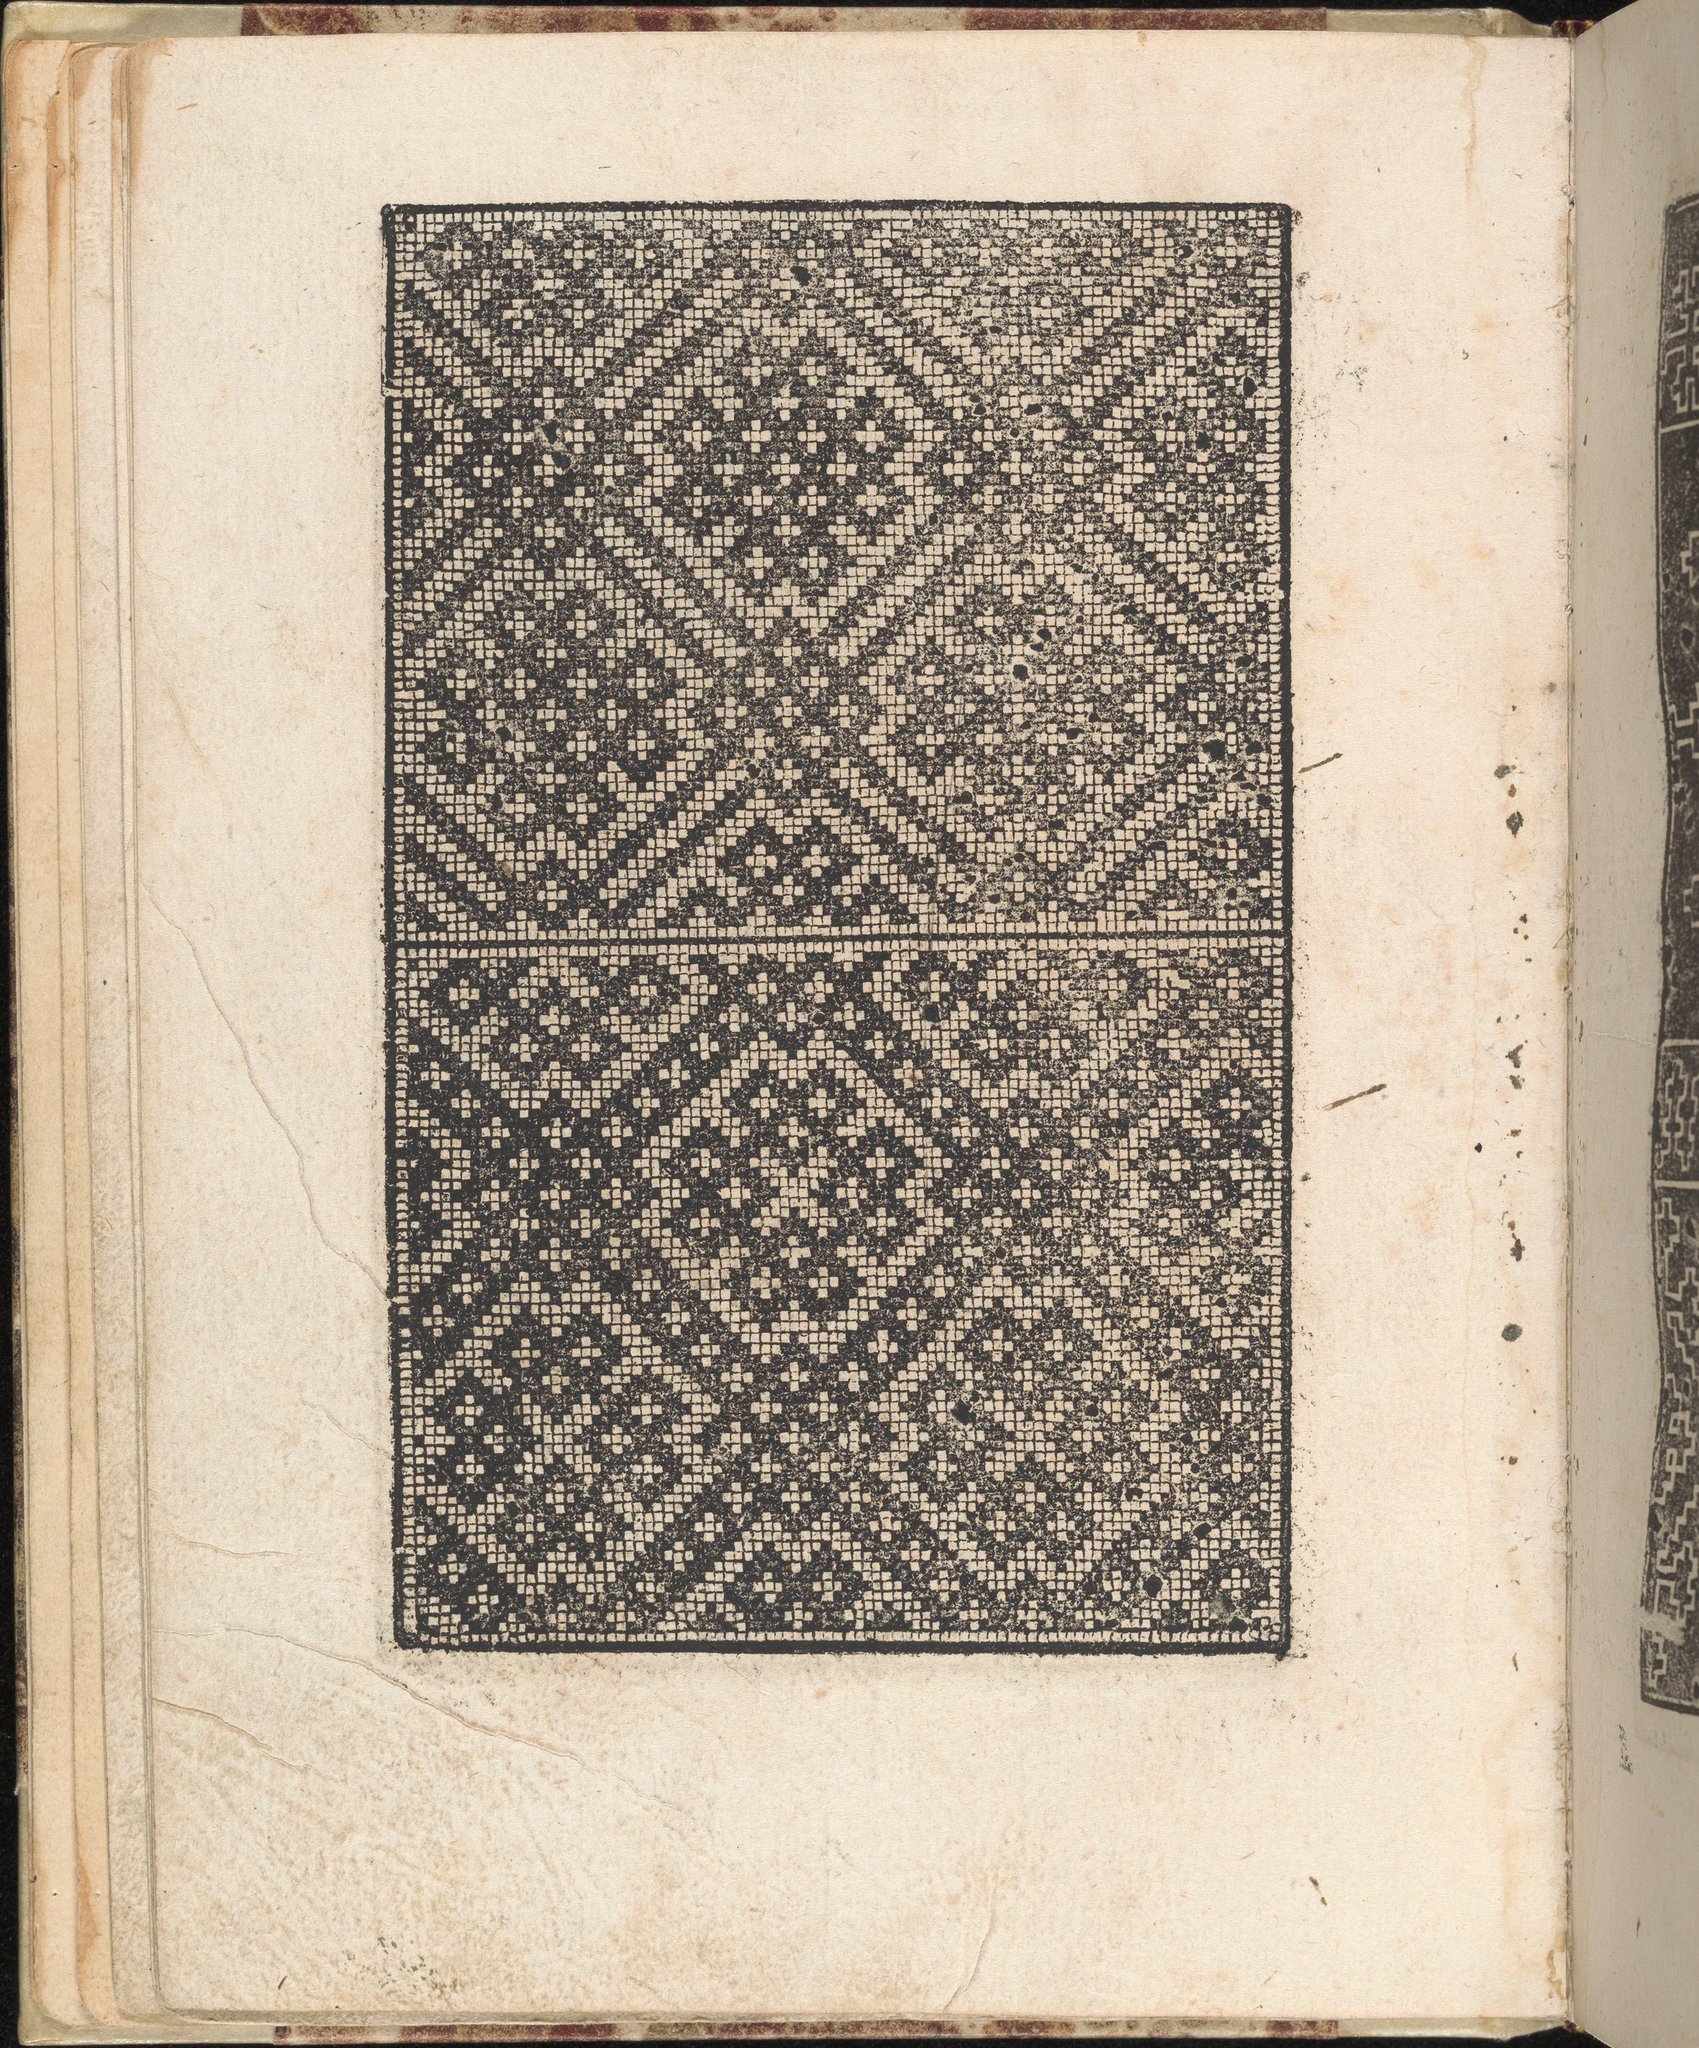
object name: book print ornament architecture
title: Ein new getruckt model Büchli...Page 11, verso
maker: johann schönsperger the younger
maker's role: publisher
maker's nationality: german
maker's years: 1490-1550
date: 1529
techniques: woodcut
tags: ornament